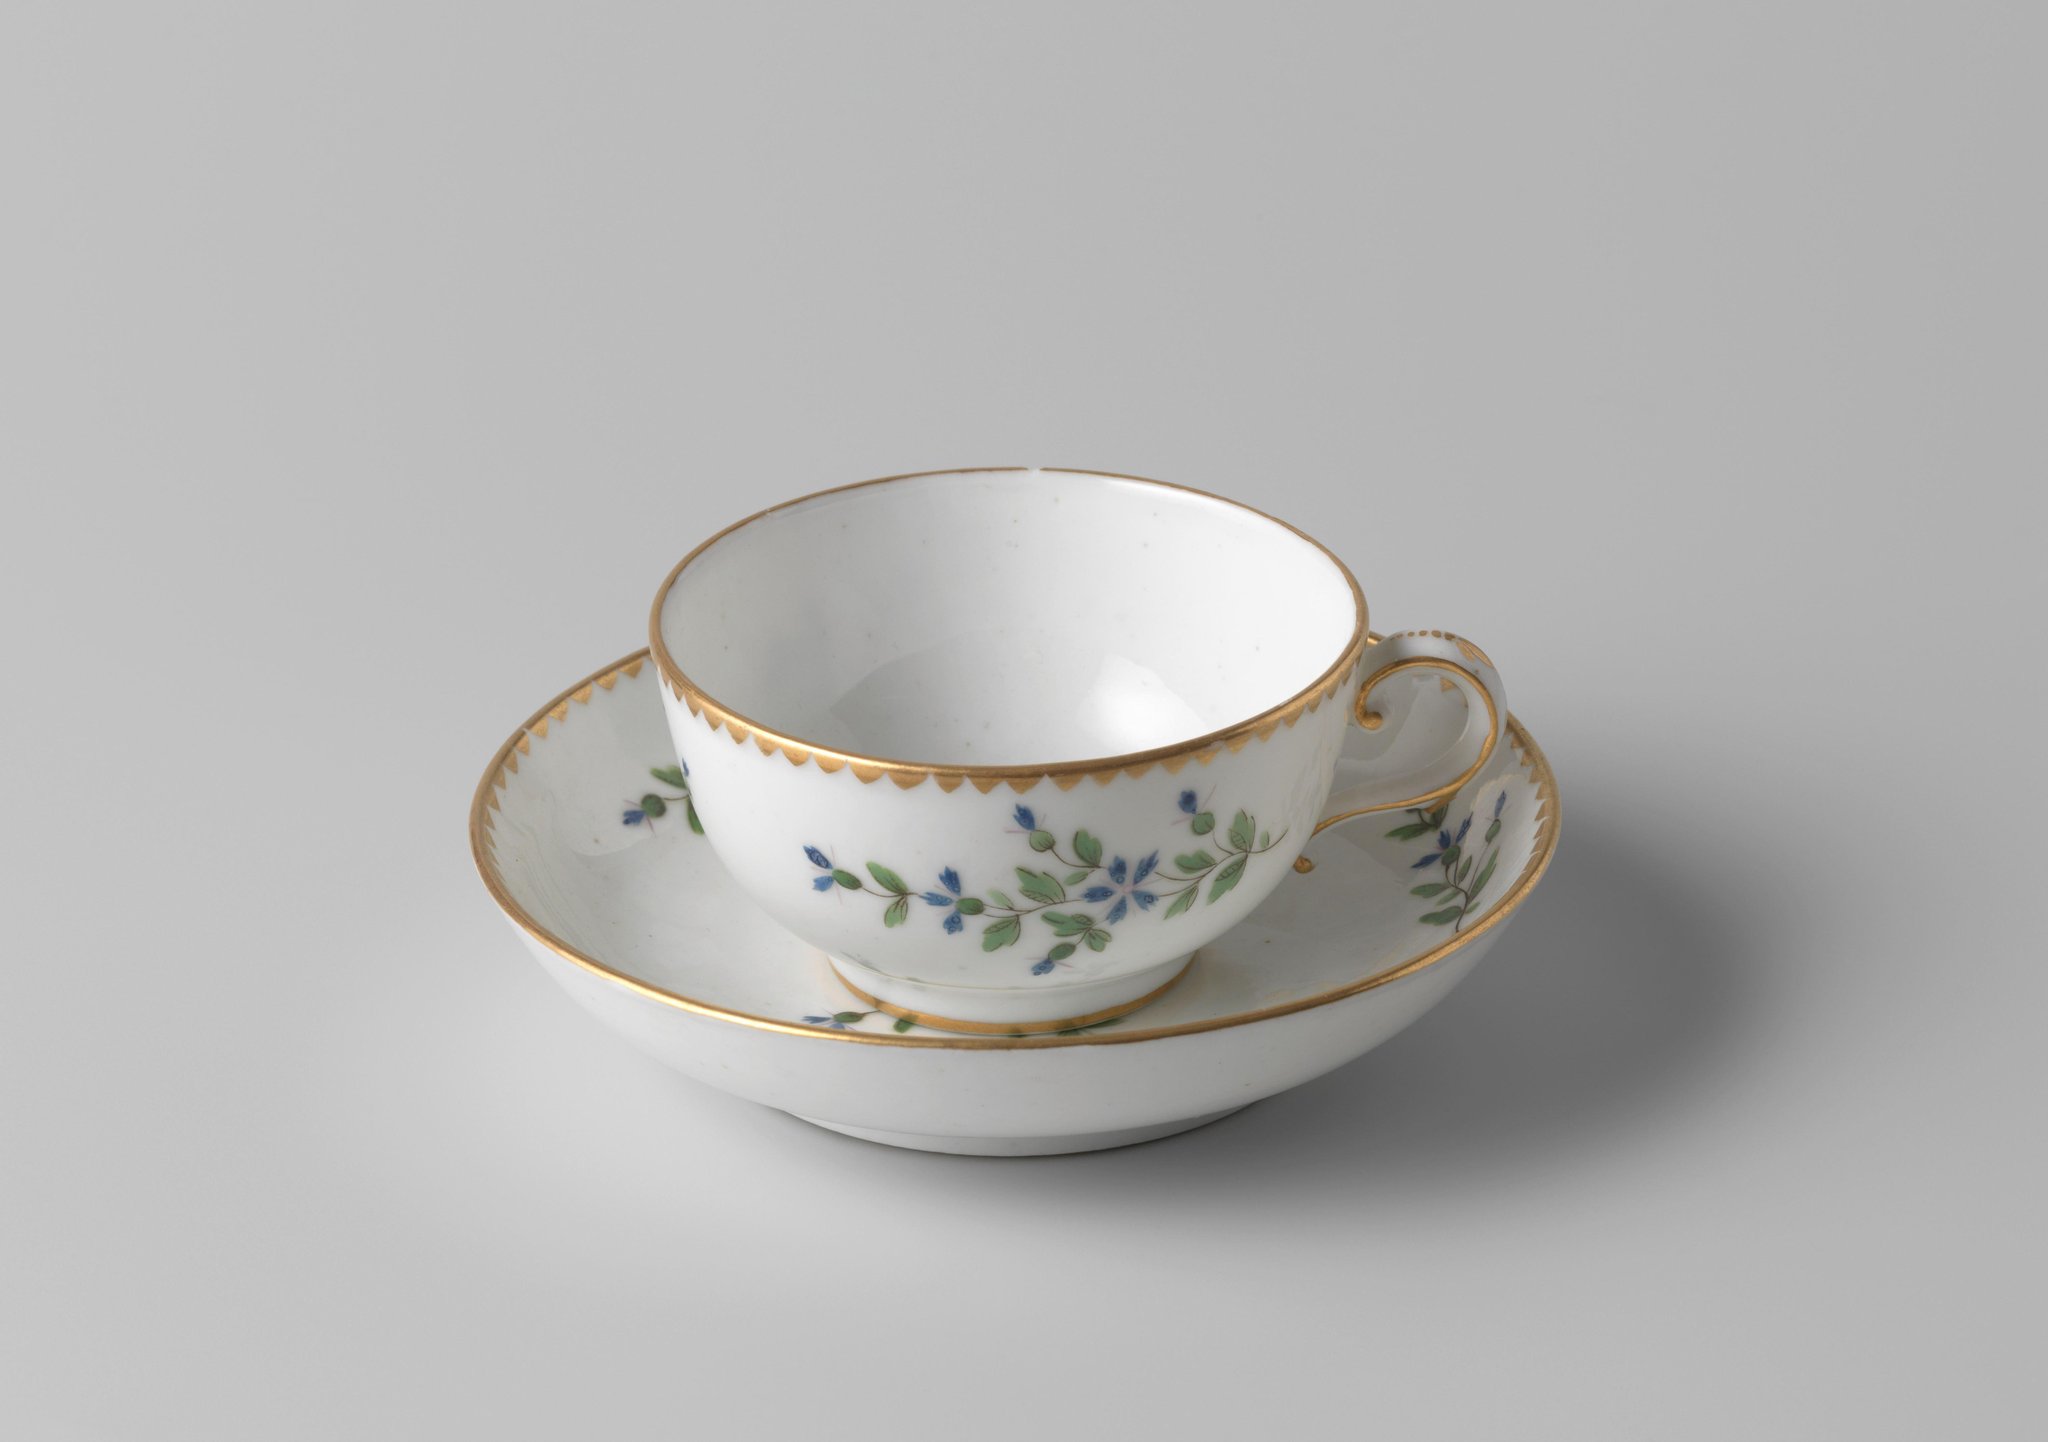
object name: platter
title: Saucer with flower sprays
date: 1790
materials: glaze, gold, paint, porcelain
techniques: firing, forming, gilding, turning, vitrification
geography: lille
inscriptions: mark: ‘gekroonde dolfijn’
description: Schotel van porselein, beschilderd op het glazuur in blauw, roze, groen, zwart en goud. Op het plat een bloemtak (korenbloem) omgeven door drie dezelfde bloemtakken op de wand. Een band met gouden driehoeken op de rand. Gemerkt op de onderzijde met de gekroonde dolfijn.